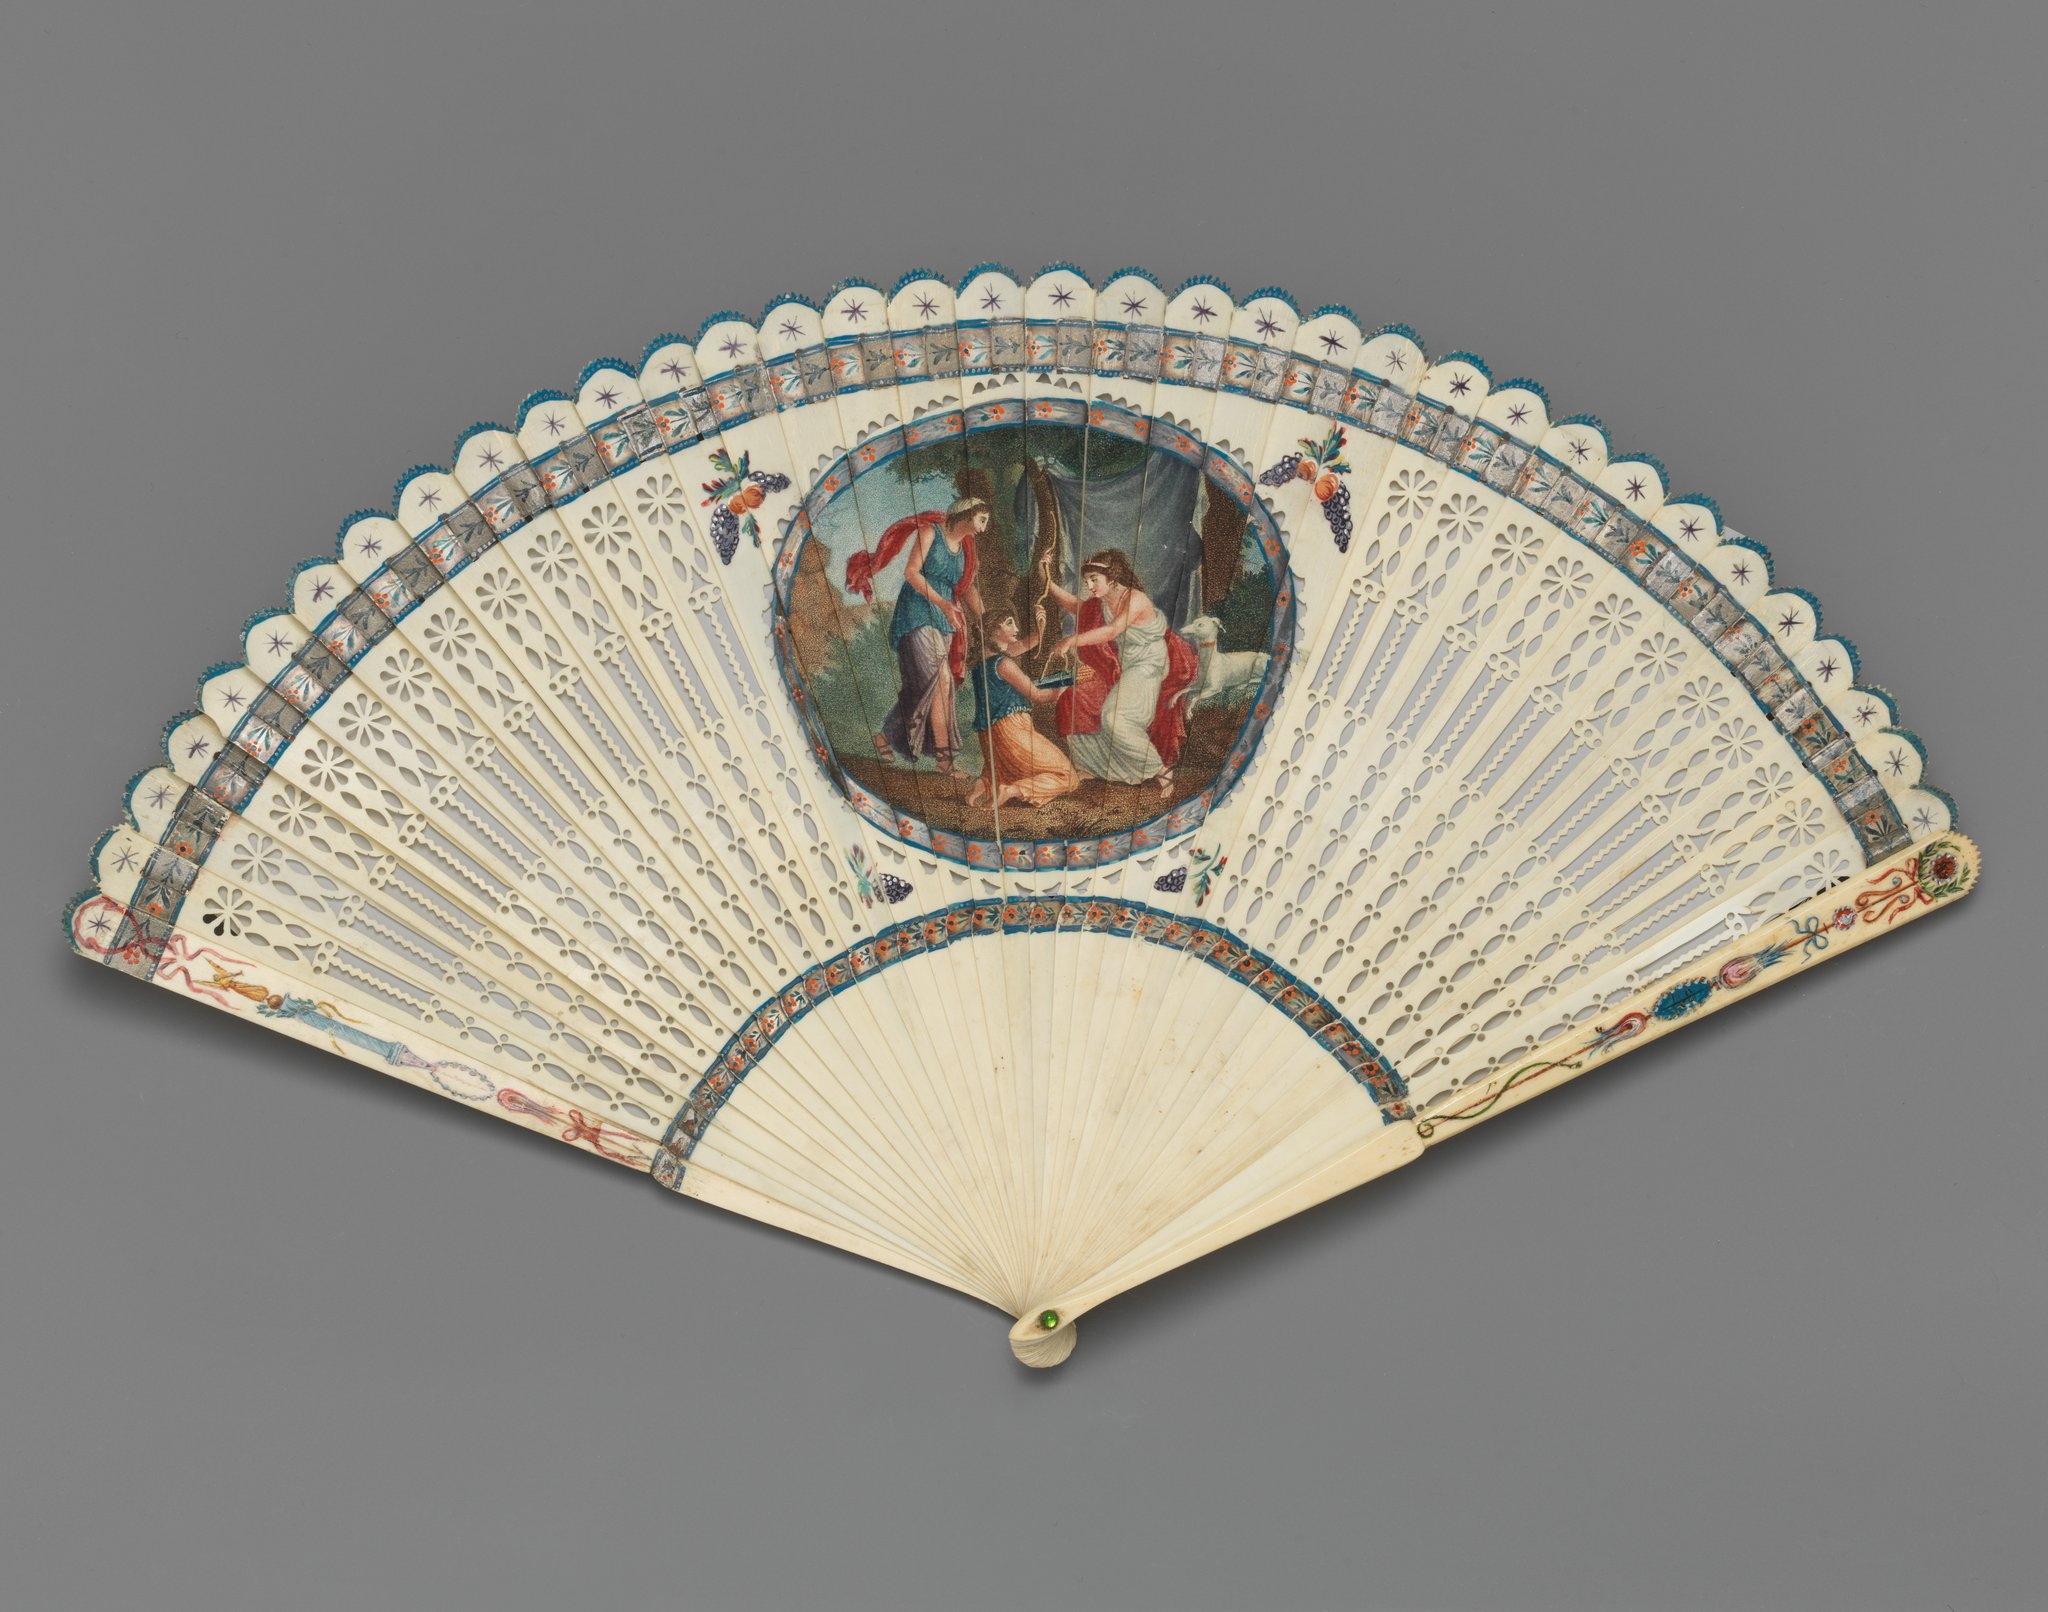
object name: fan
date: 1767-1800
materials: ivory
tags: bow and arrow,women,dogs